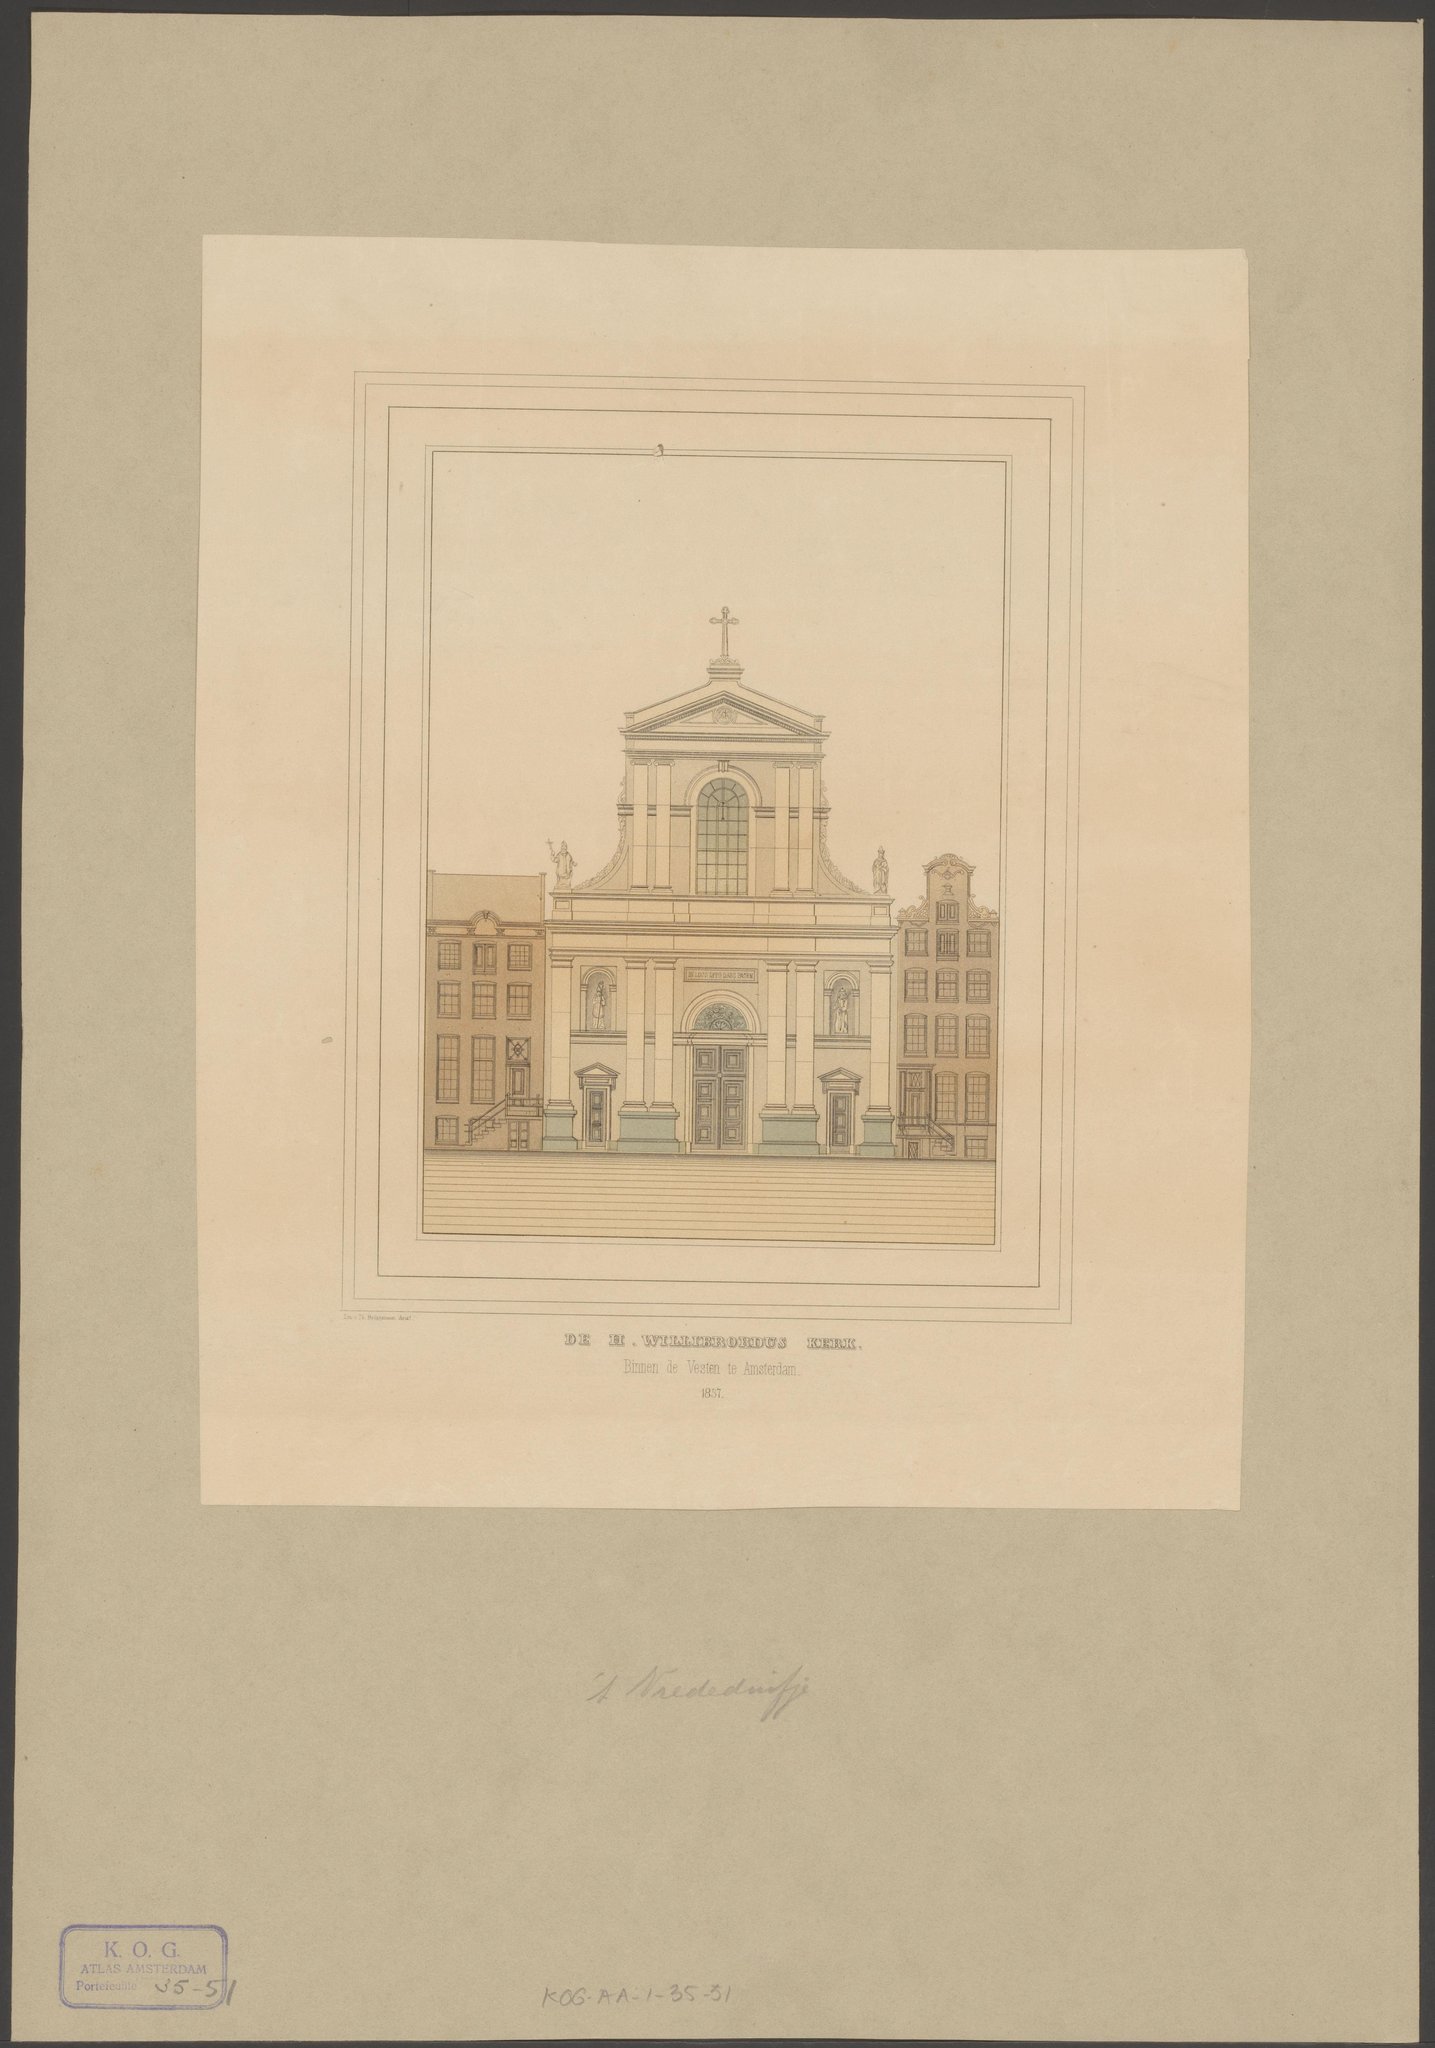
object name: print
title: De H. Willibrordus Kerk. Binnen de Vesten te Amsterdam. 1857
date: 1857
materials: paper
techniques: lithograph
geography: amsterdam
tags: roman catholic church, parts of church exterior and annexes: façade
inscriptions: collector's mark: ‘35-51’ Lugt 1641b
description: Onderwerpsrubriek binnen de Atlas Amsterdam: R.K. Gemeenten: Sint Nicolaaskerk t/m Willibrordus (Rustenburgerstraat).